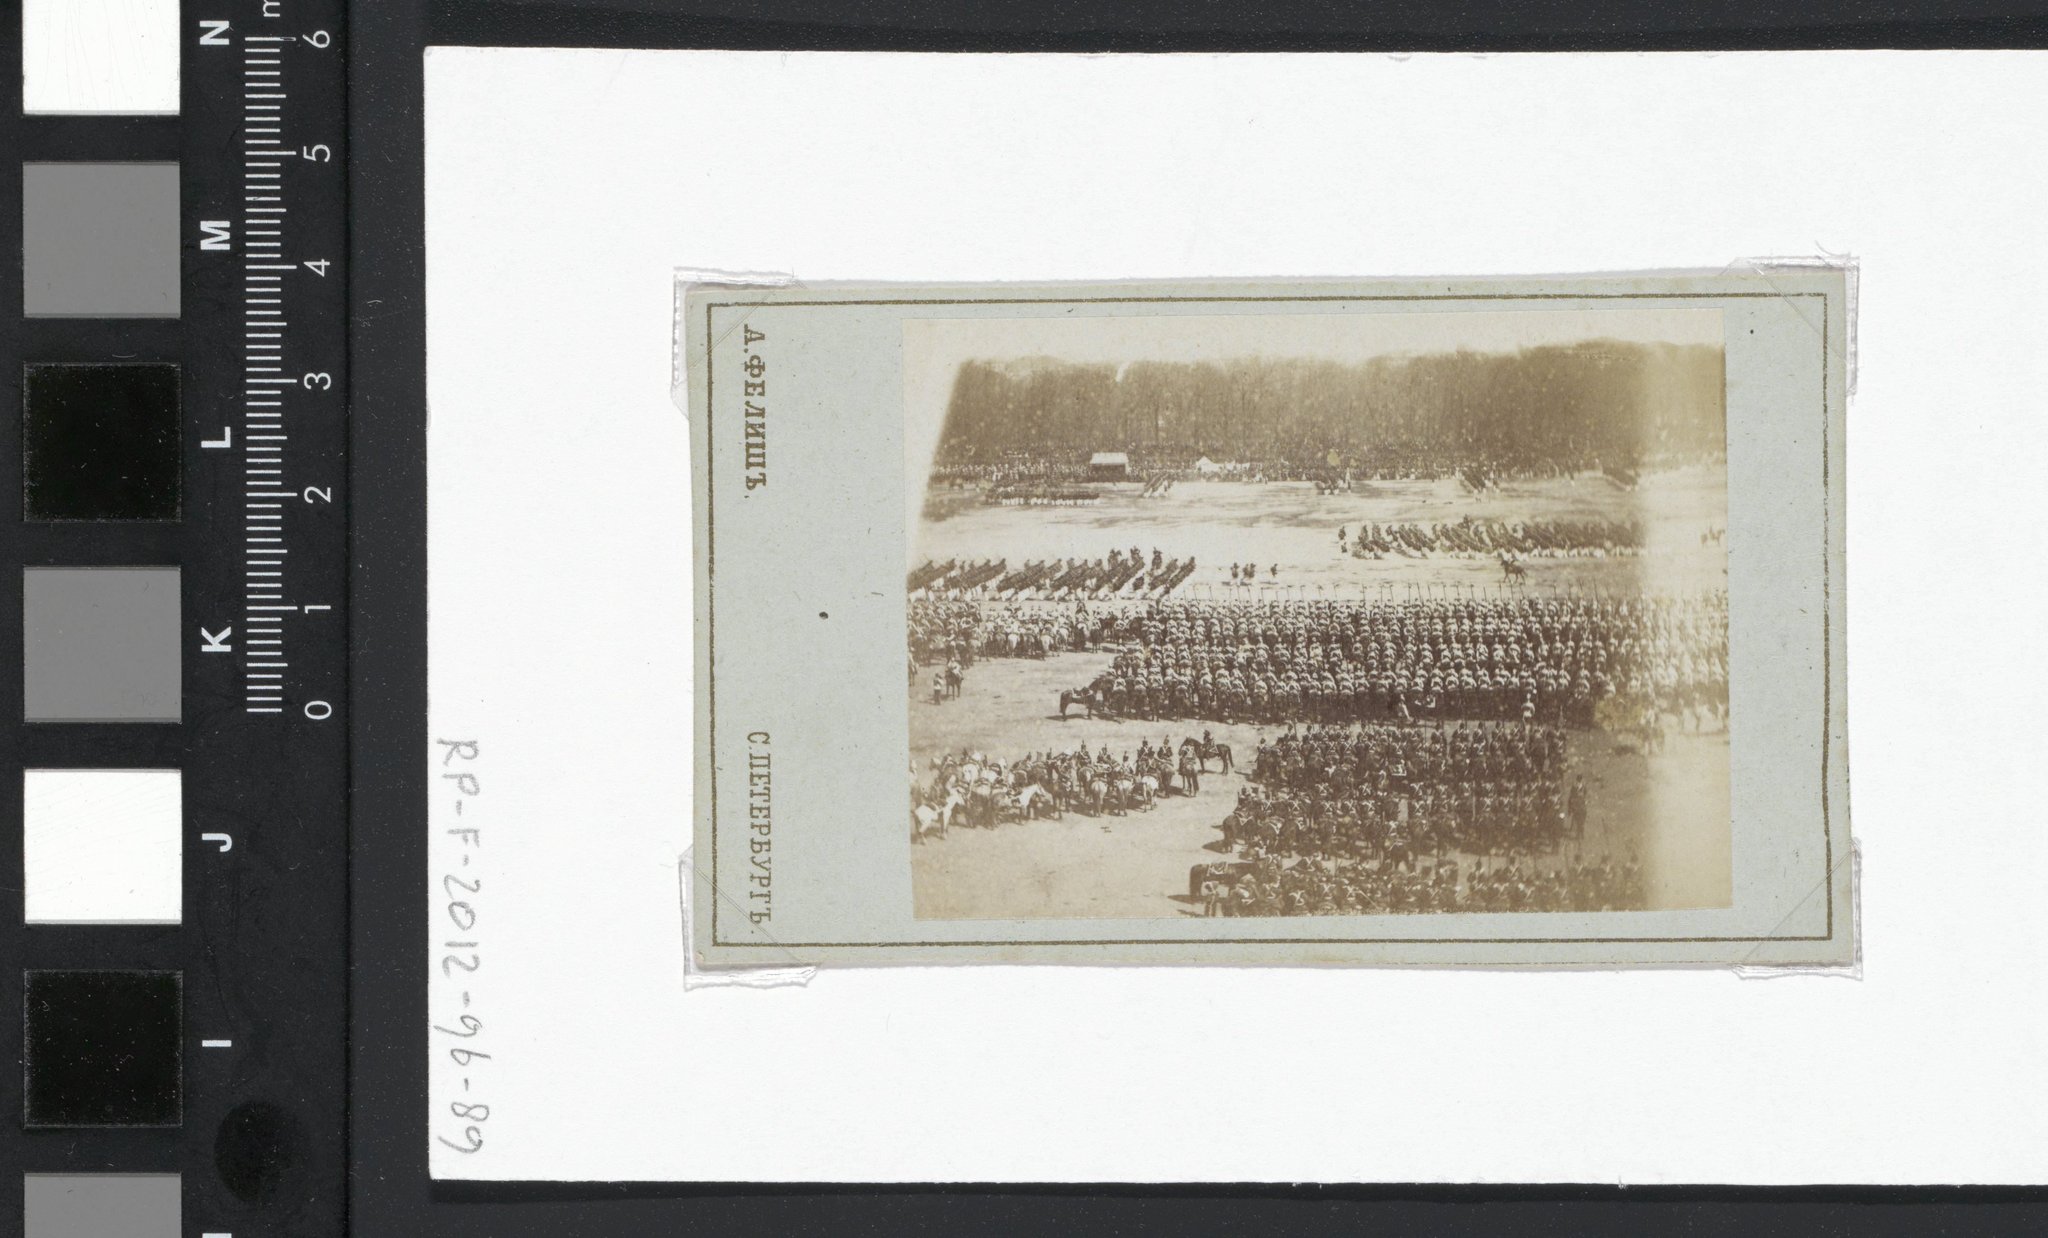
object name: photograph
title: Militaire parade in Rusland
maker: albert felisch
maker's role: fotograaf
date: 1880-1900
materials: cardboard, paper, photographic support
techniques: albumen print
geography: sint-petersburg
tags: military parade, pageant